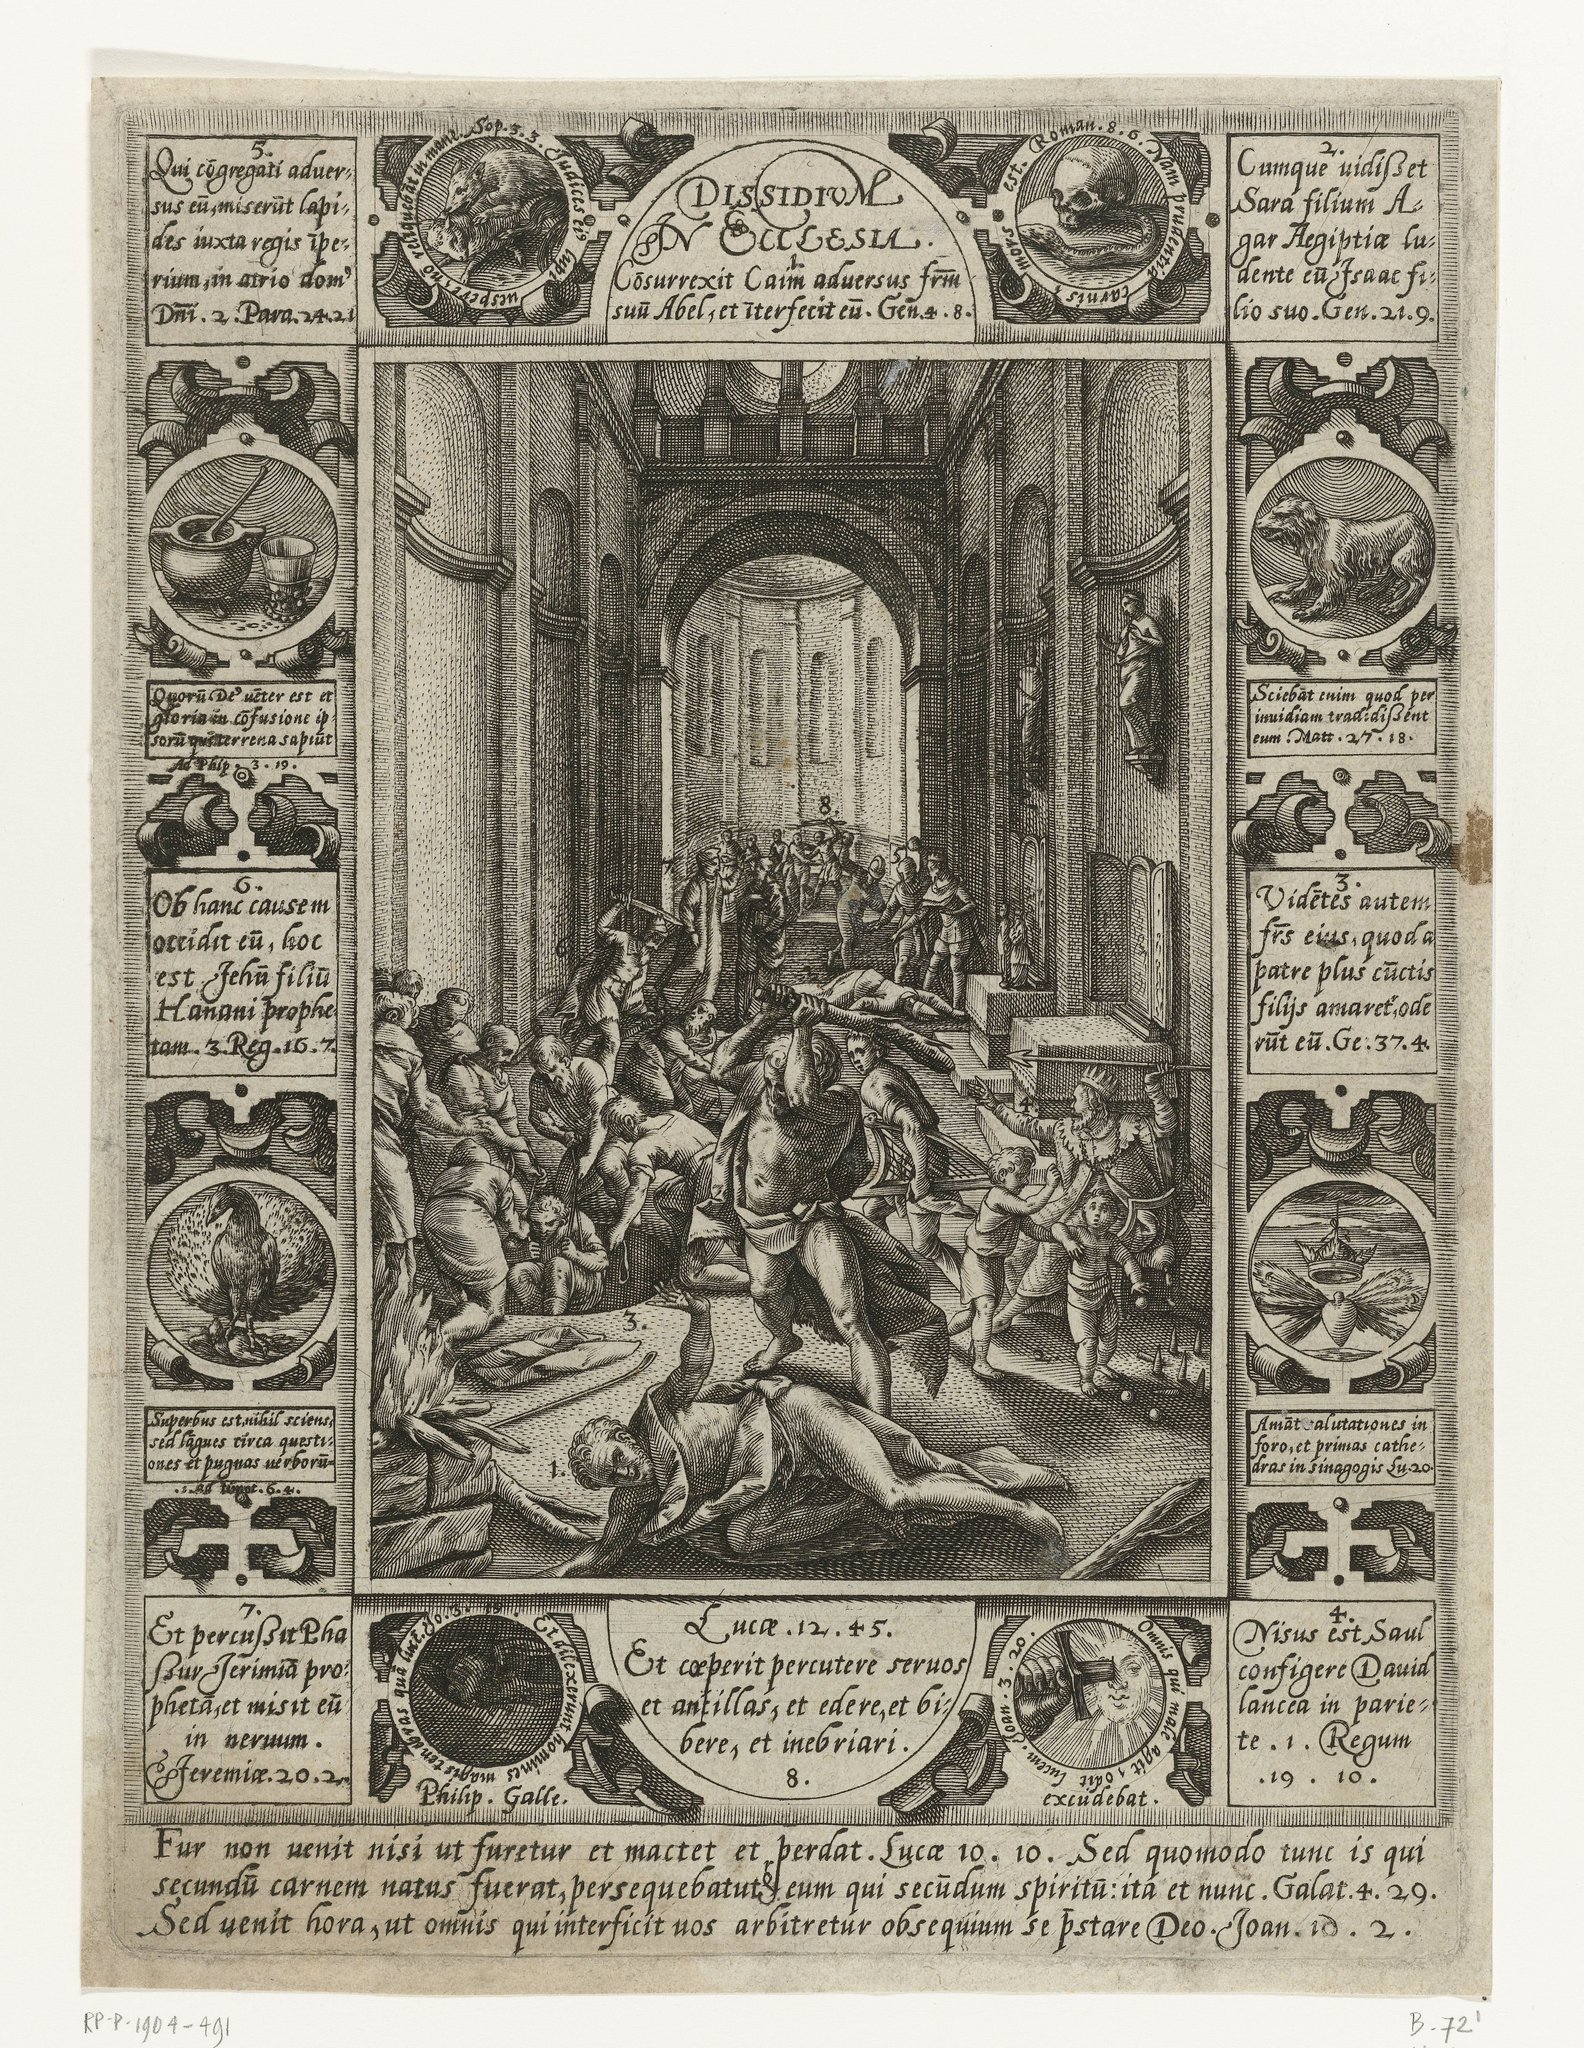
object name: print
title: Dissidium in Ecclesia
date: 1578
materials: paper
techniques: engraving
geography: haarlem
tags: fighting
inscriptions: collector's mark: Lugt 2228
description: Allegorieën met een centrale voorstelling van een kerkinterieur waar verschillende bijbelse figuren elkaar te lijf gaan met daaromheen een omlijsting waarin citaten uit de bijbel gecombineerd zijn met de verbeelding van bepaalde gebeurtenissen uit de bijbel. In de marge onderaan drie bijbelteksten in Latijn.